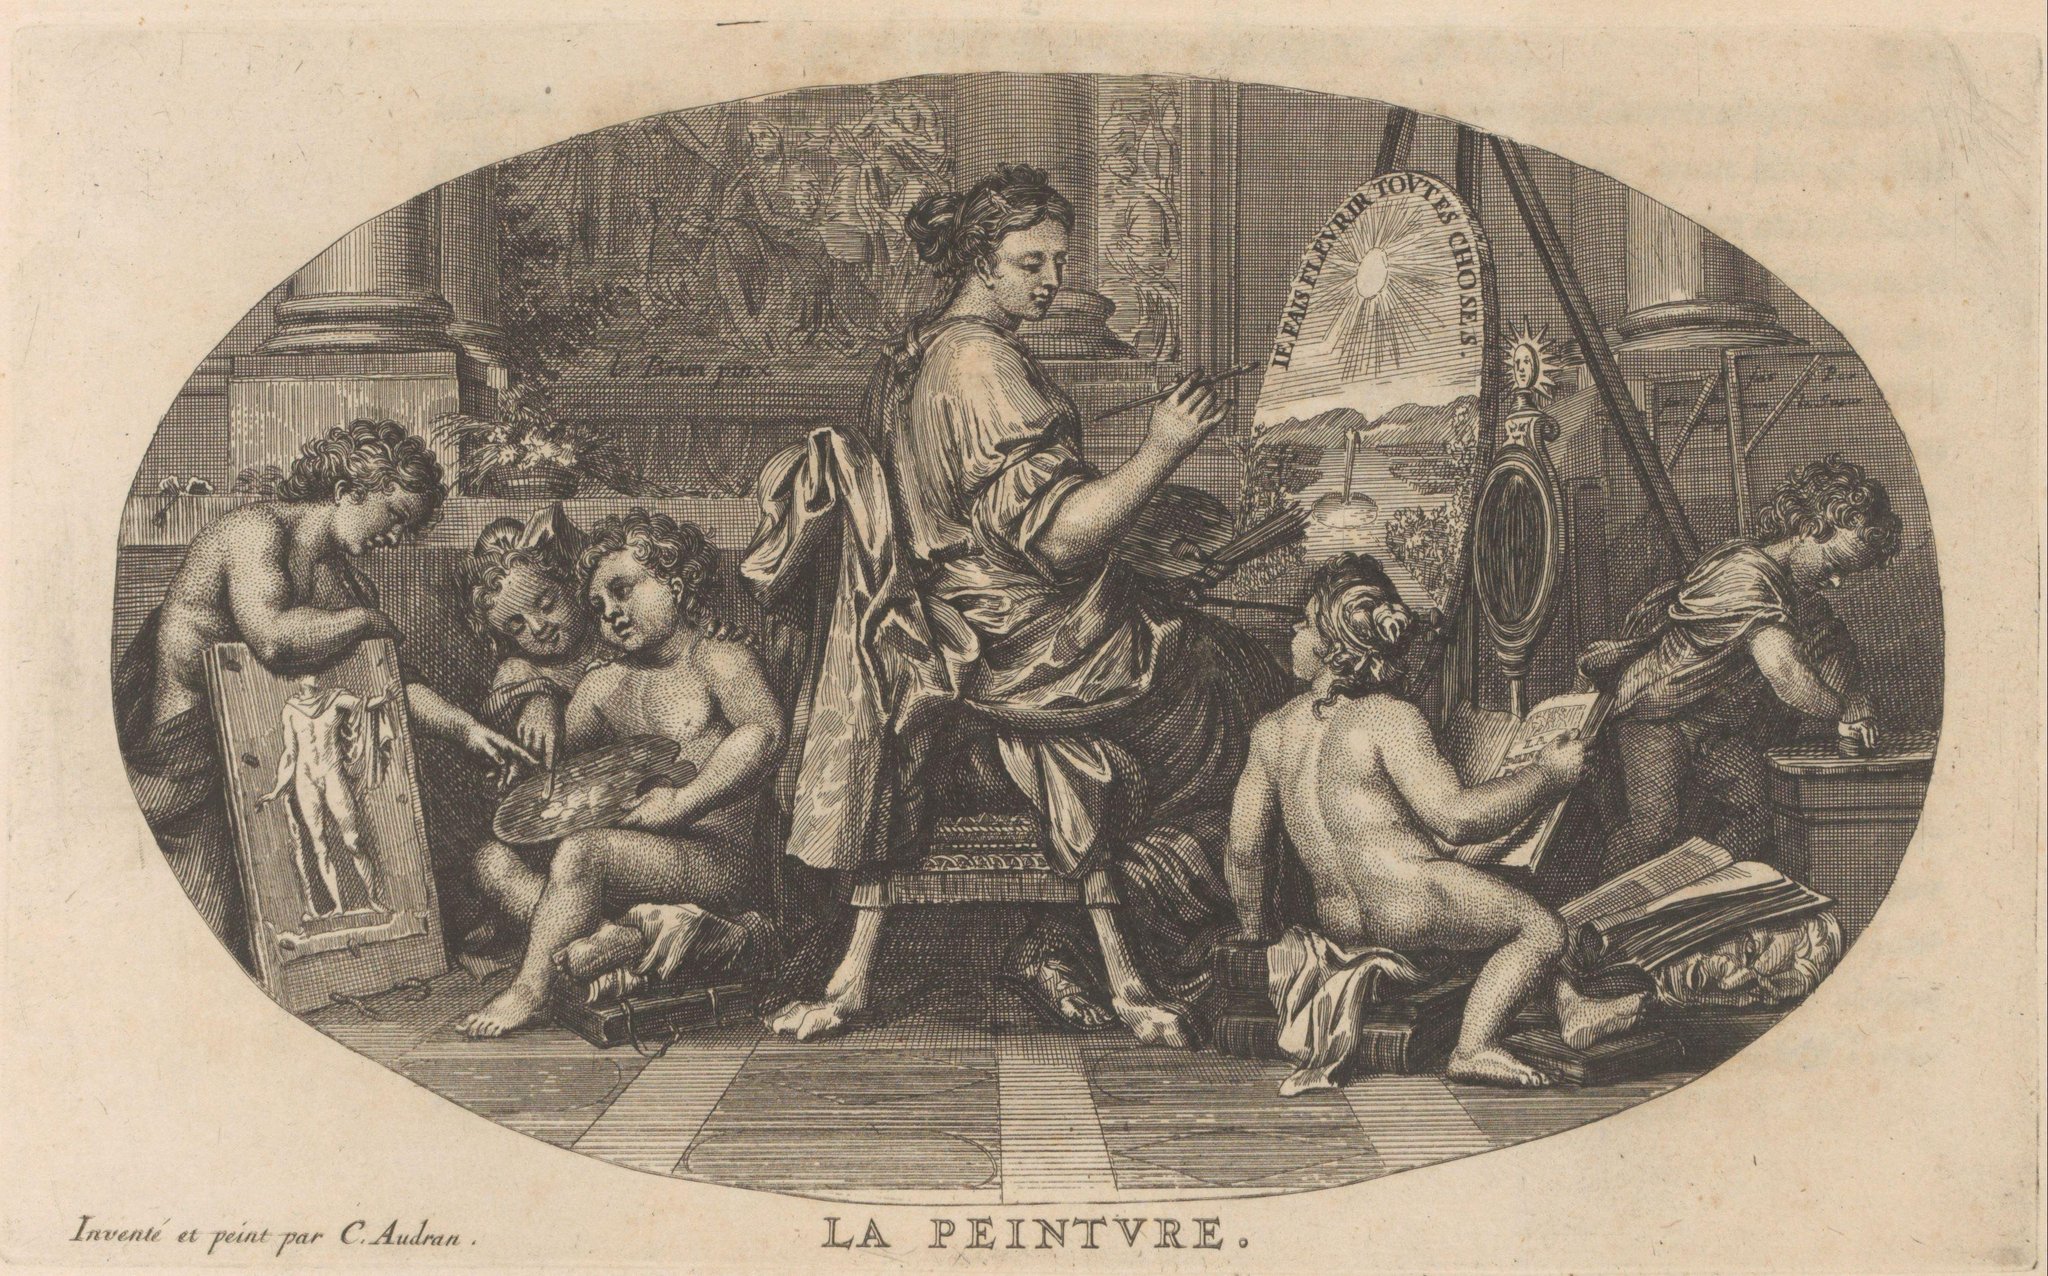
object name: album leaf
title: Le Cabinet des Beaux Arts, ou Recueil Des Plus Belles Estampes, gravées d'aprés les Tableaux Originaux (...)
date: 1695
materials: paper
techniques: engraving, etching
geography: paris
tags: 'pictura', symbolic representations, allegories and emblems ~ painting; 'pittura' (ripa), (decorated) ceiling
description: Plafondstuk met de personificatie van Schilderkunst. Zij houdt penseel en schilderspalet in haar handen en werkt aan een schilderij. Putti assisteren haar. Geheel rechts wrijft een putto verf. Prent maakt deel uit van een album.